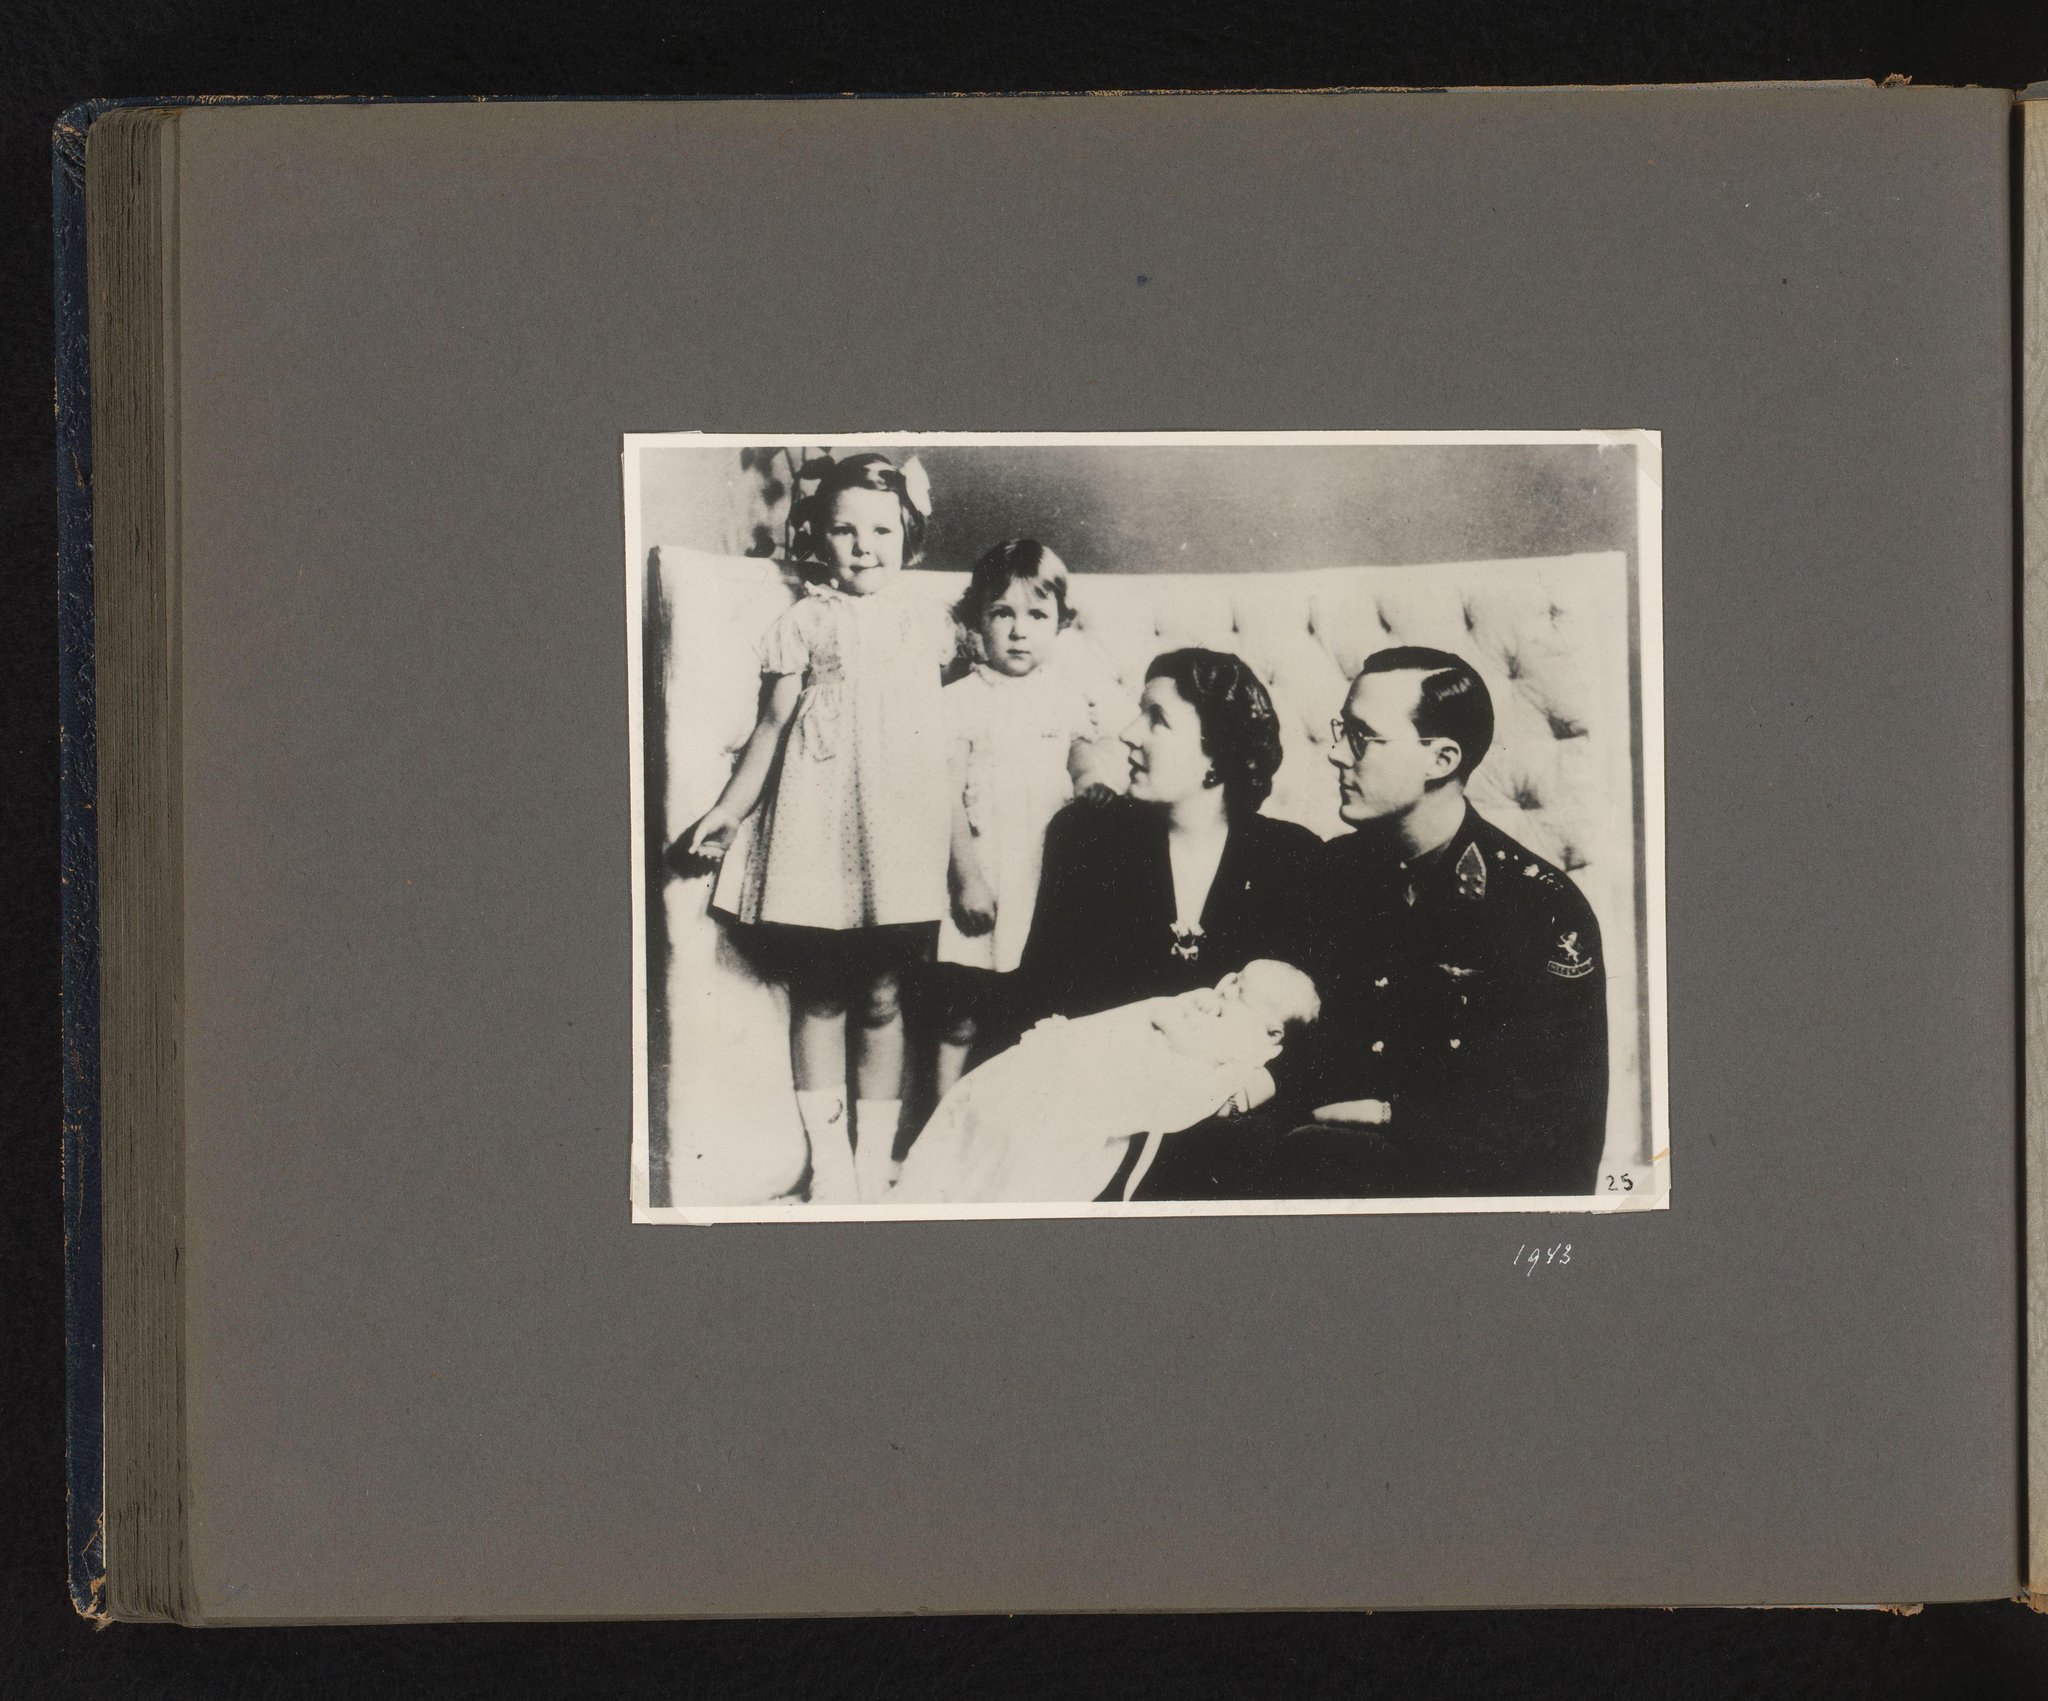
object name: album leaf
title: Koninklijke Familie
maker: Anonymous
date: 1943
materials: cardboard, photographic support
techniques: gelatin silver print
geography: canada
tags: utrecht, bernhard (prins der nederlanden), beatrix (koningin der nederlanden), the hague, juliana of the netherlands, parents with their children, canada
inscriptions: inscription: ‘Canada 1943’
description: Albumblad met een foto van de Koninklijke Familie in Canada, 1943. Onderdeel van fotoalbum over het familieleven van de leden van het Koninklijk Huis tussen 1937-1945.